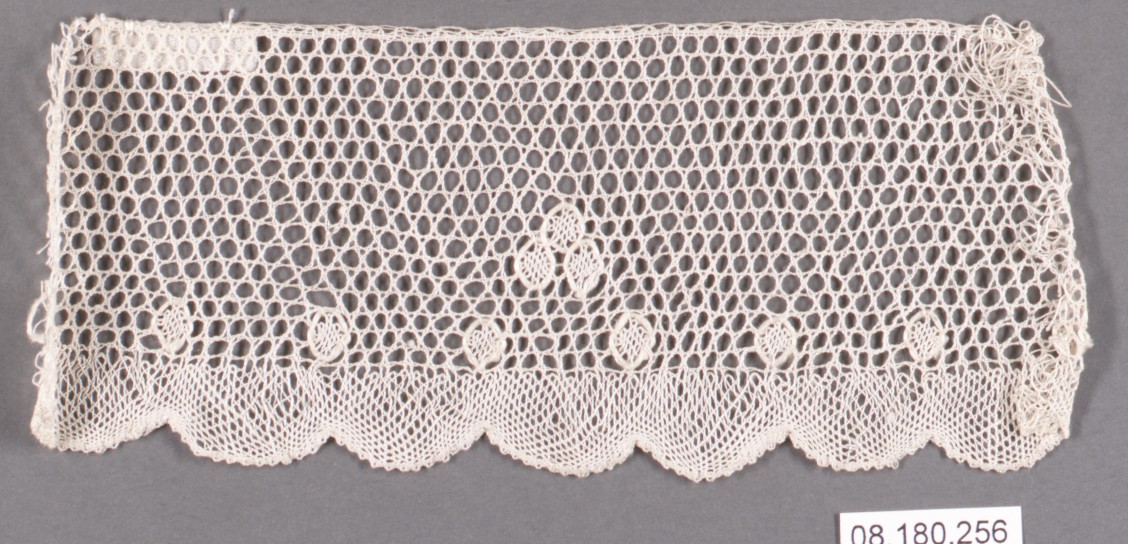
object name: fragment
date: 1701-1800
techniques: lace